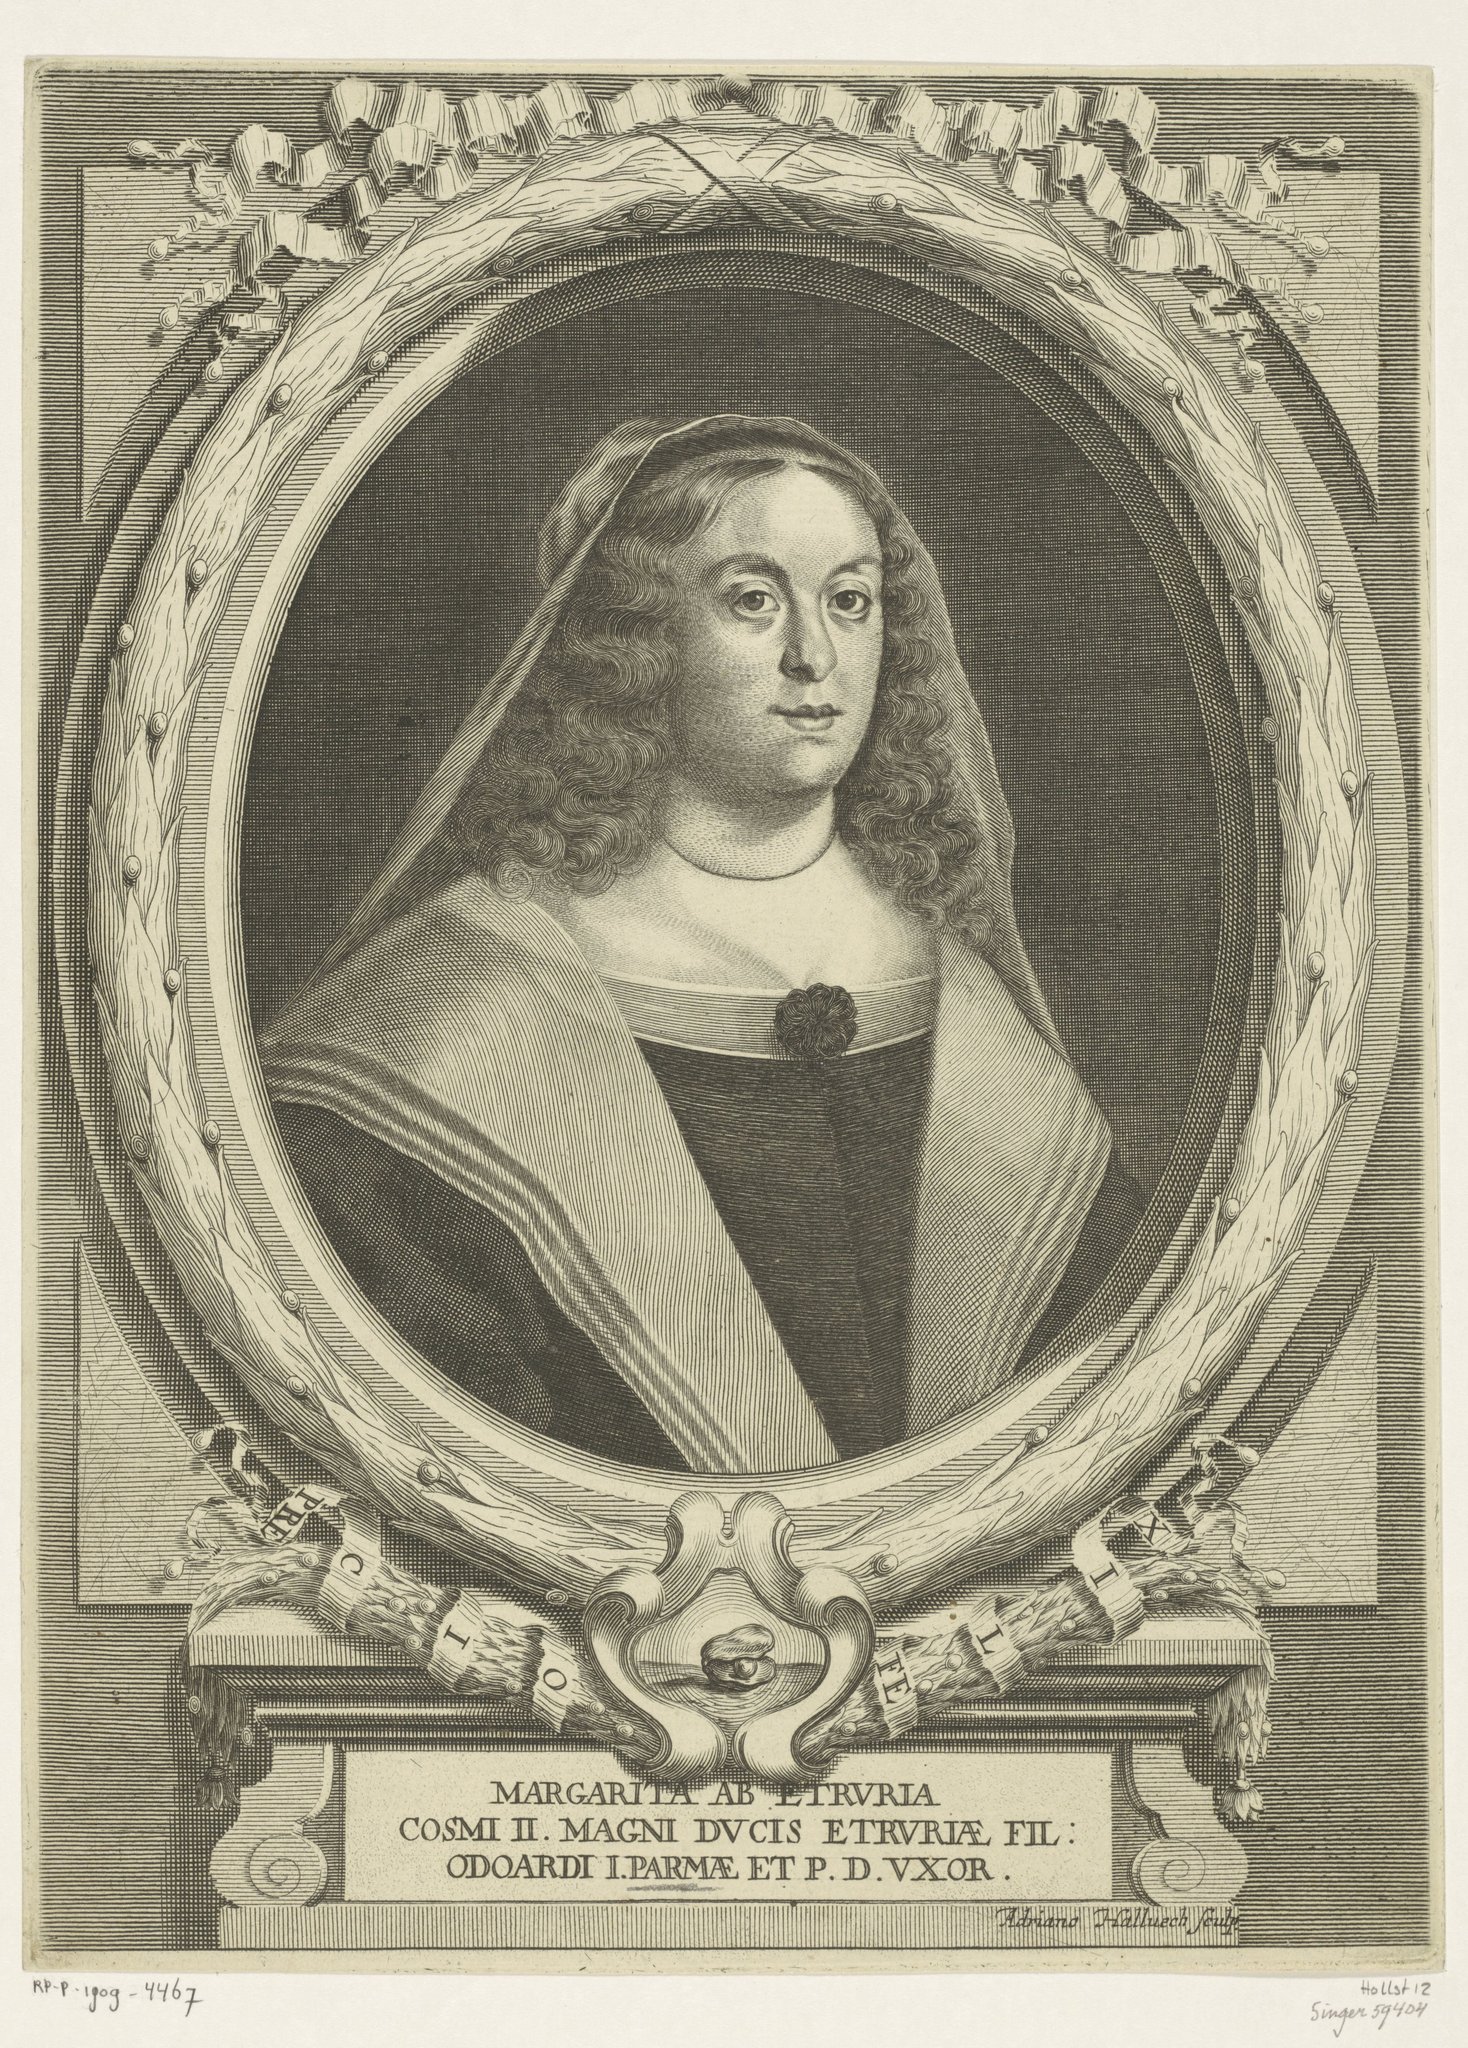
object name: print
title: Portretten van de familie De' Medici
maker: adriaen haelwegh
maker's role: print maker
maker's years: 1637-1702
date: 1647-1696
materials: paper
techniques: engraving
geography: northern netherlands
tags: veil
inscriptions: collector's mark: Lugt 2228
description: Portret ten halven lijve naar rechts van Margaretha de Medici, dochter van Cosimo II en echtgenote van Odoardo Farnese hertog van Parma, in een ovaal omringd met een lauwerkrans. Onderaan in een cartouche een oester met een parel, daaronder op een tablet onder een plint haar naam en twee regels in Latijn.